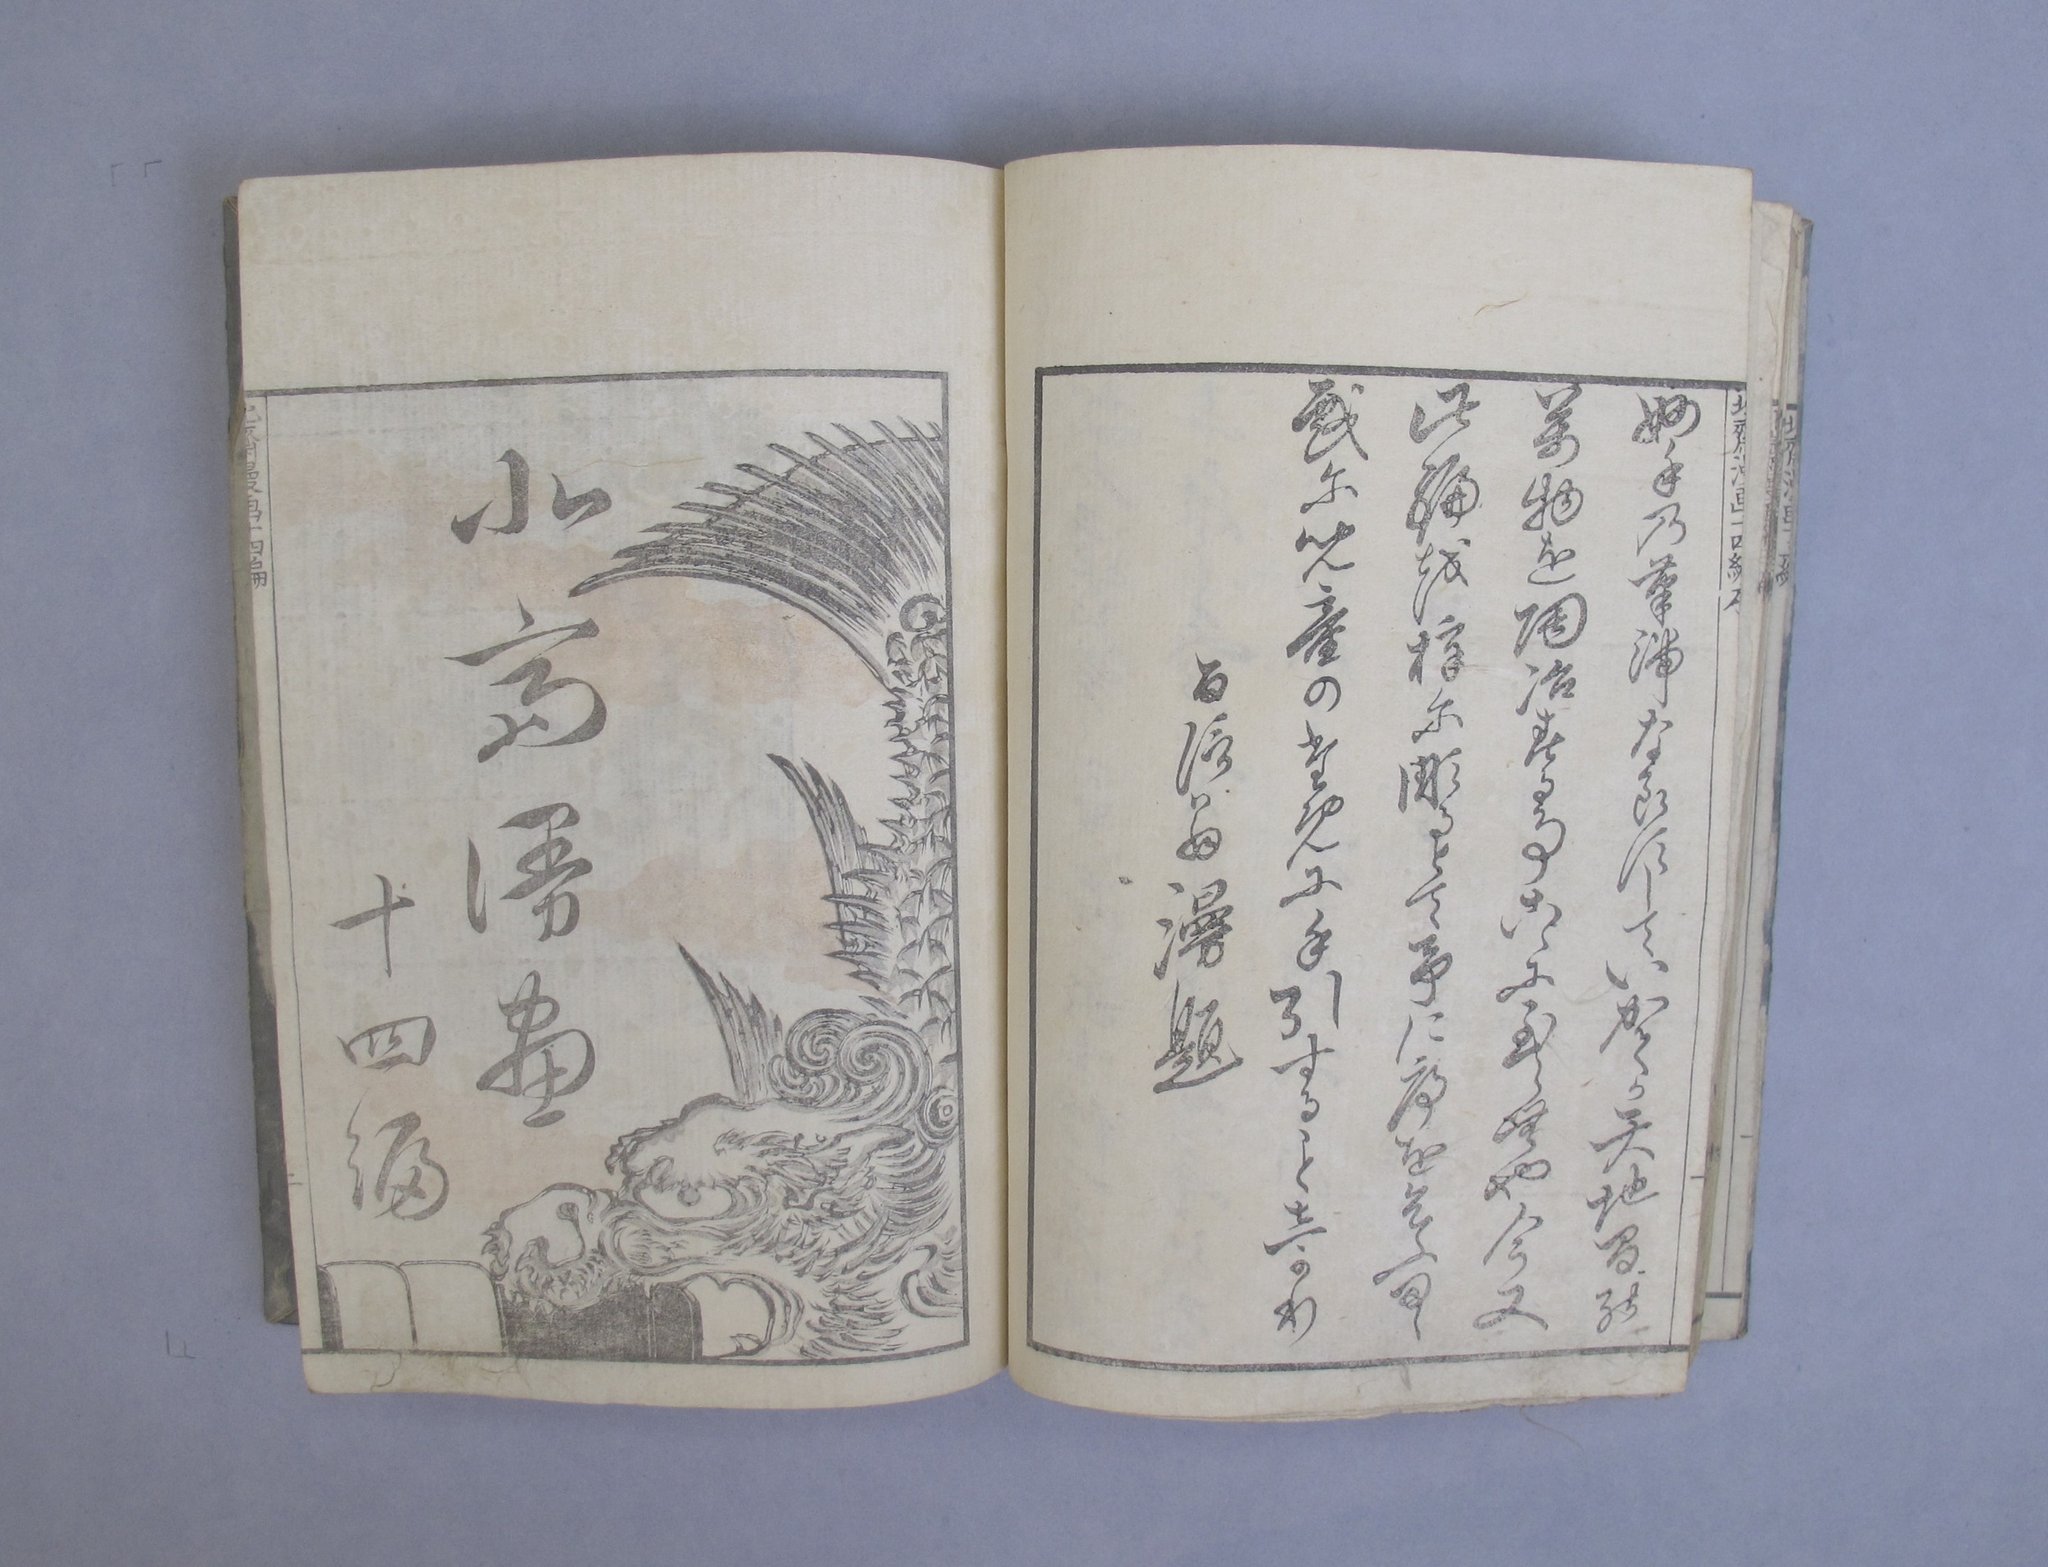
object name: illustrated book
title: Transmitting the Spirit, Revealing the Form of Things: Hokusai Sketchbooks, volume 14 (Denshin kaishu: Hokusai manga, jūyonpen)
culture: japanese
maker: katsushika hokusai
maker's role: artist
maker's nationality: japanese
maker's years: 1760-1849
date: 1875-1878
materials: ink, paper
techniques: woodblock print